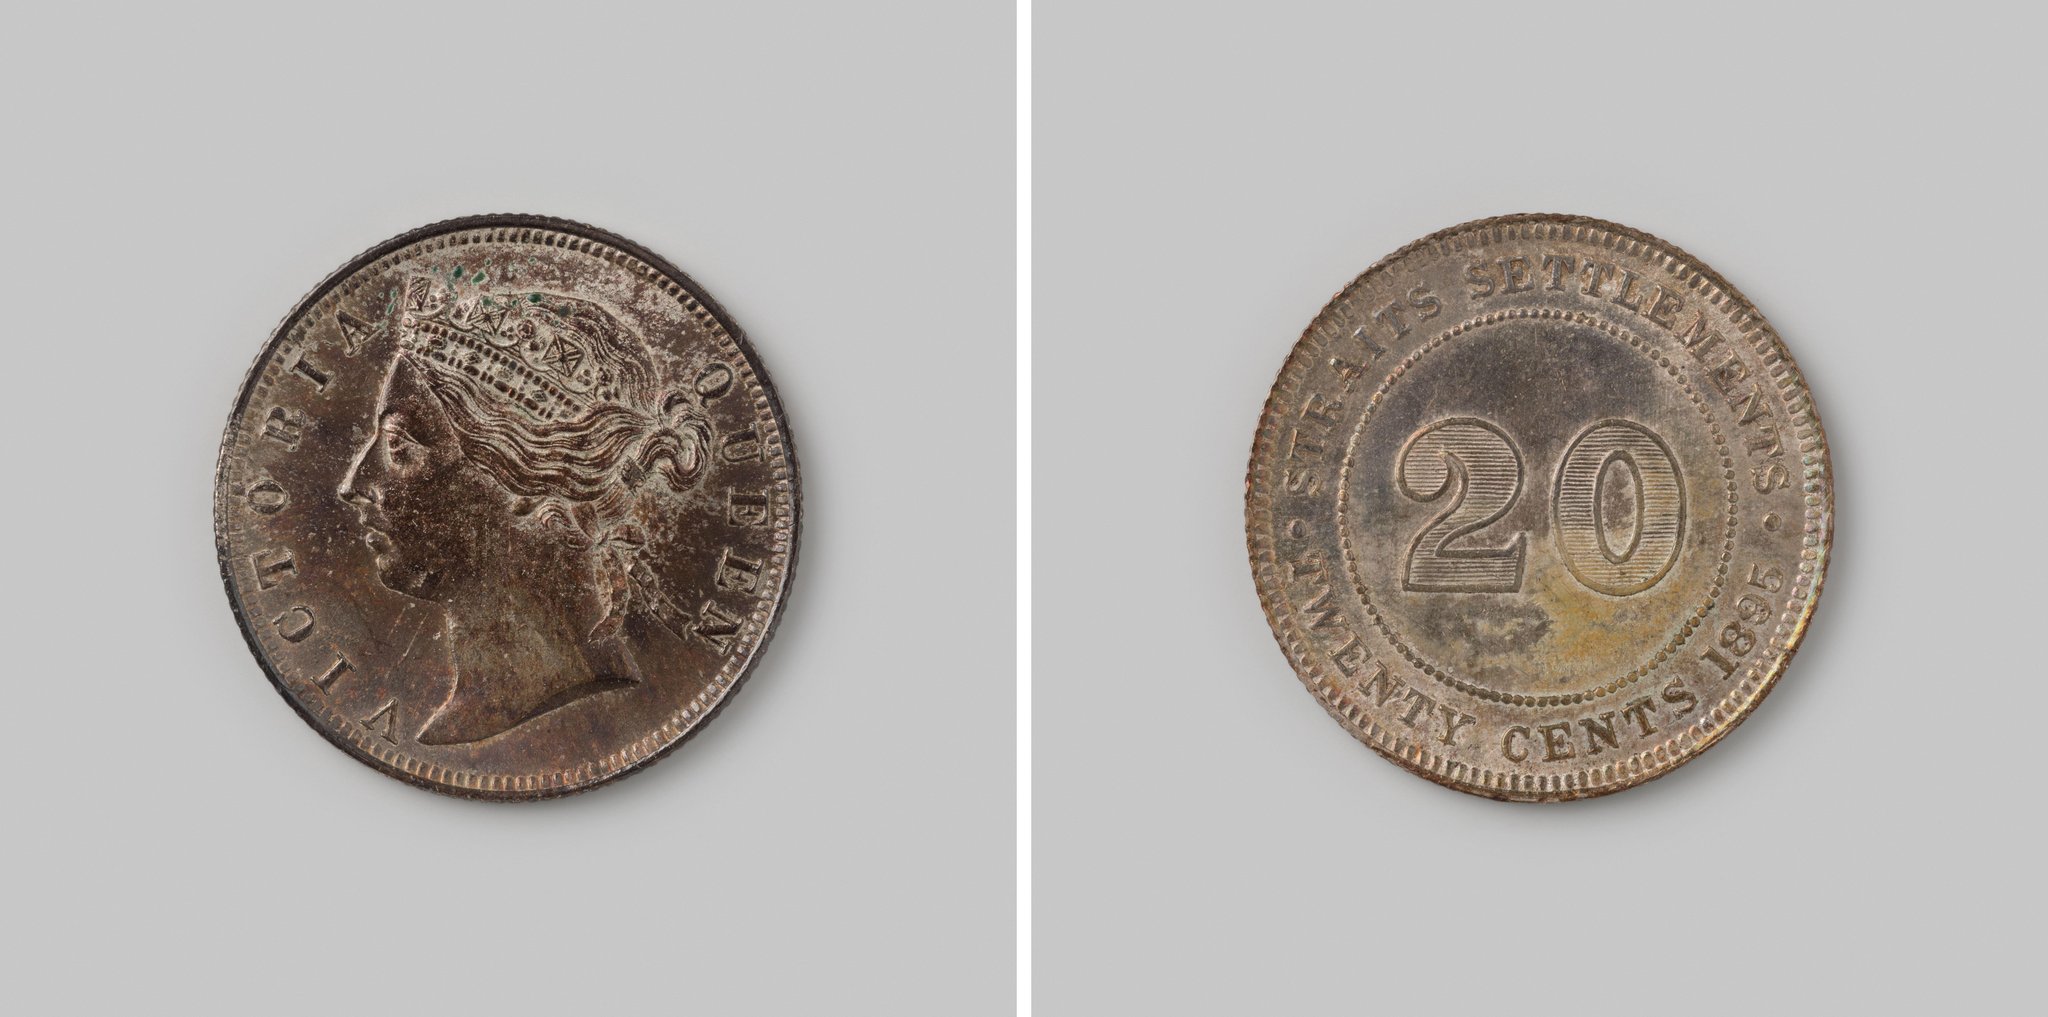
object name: coin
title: 20 cents uit de Straits Settlements van koningin Victoria, 1895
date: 1895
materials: silver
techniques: striking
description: Zilveren munt. Voorzijde: gekroond hoofd van koningin Victoria naar links. Keerzijde: binnen parelcirkel waarde-aanduiding: 20. In omschrift onderaan waarde-aanduiding: twenty cents met rechts daarvan jaartal. Kartelrand.